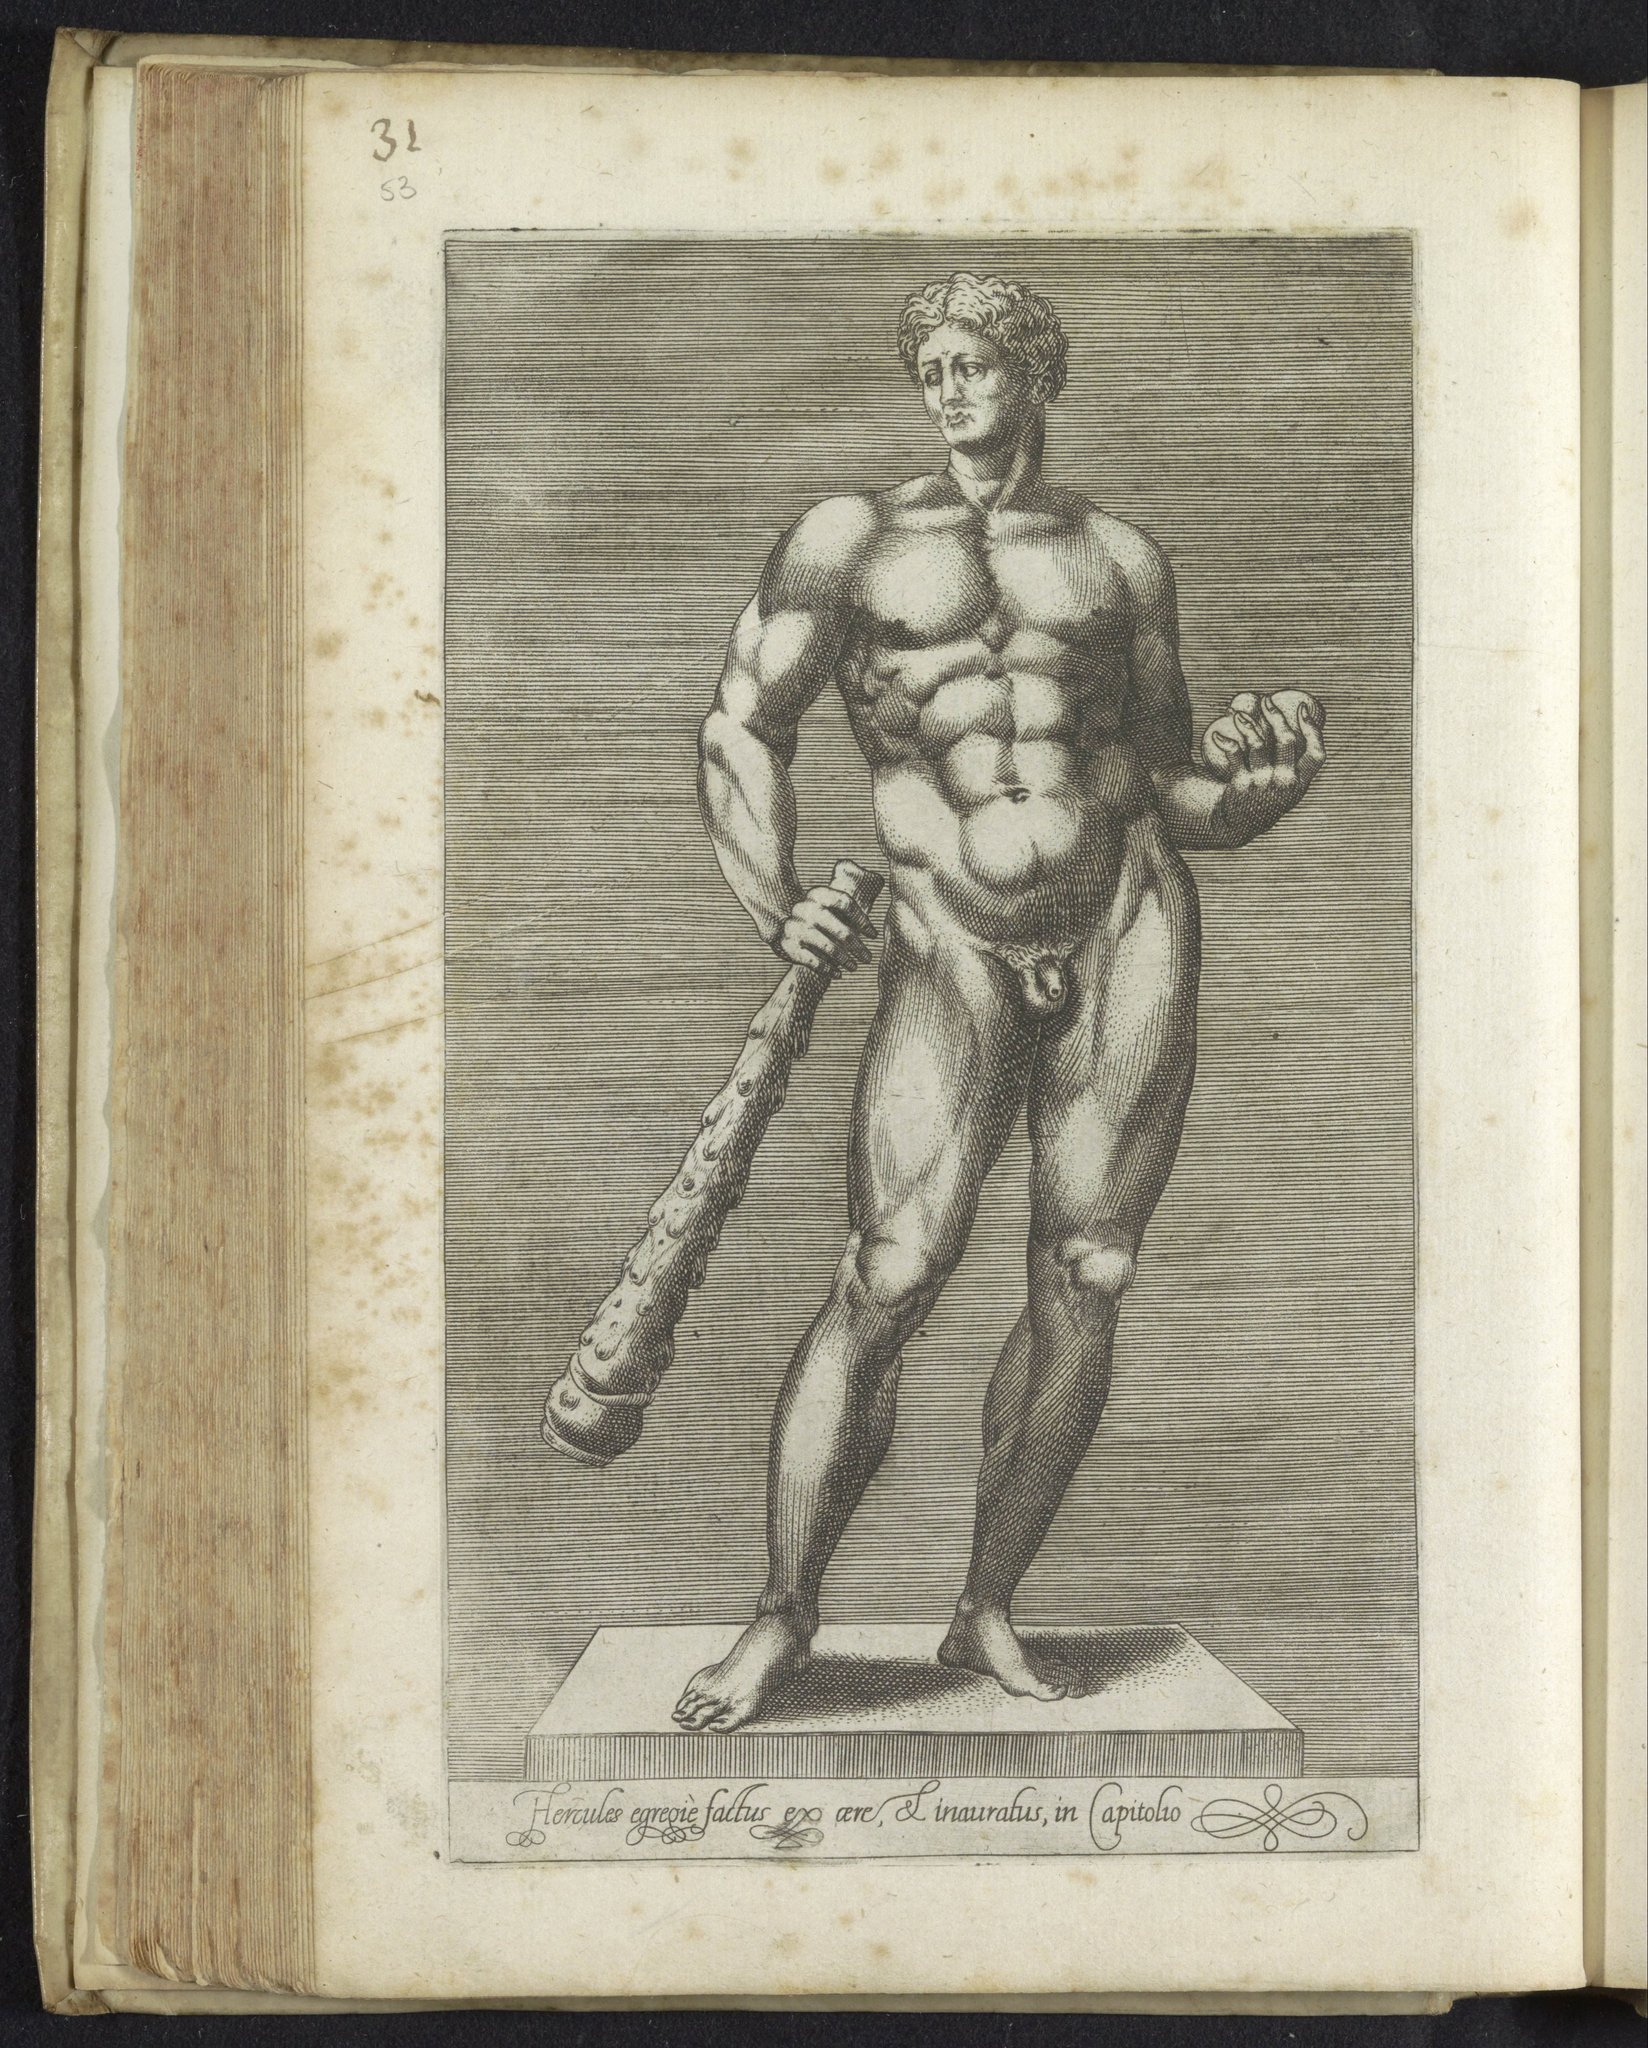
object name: album leaf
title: Antieke sculpturen in Rome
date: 1584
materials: paper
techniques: engraving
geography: italy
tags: (story of) hercules (heracles), piece of sculpture, reproduction of a piece of sculpture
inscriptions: number: ‘31’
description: Naar een antiek beeld in de Capitolijnse Musea te Rome. Het beeld staat bekend als de Hercules van het Forum Boarium. Deze prent maakt deel uit van een set van 79 prenten (+ titelprent) met voorstellingen van antieke sculpturen in Rome.